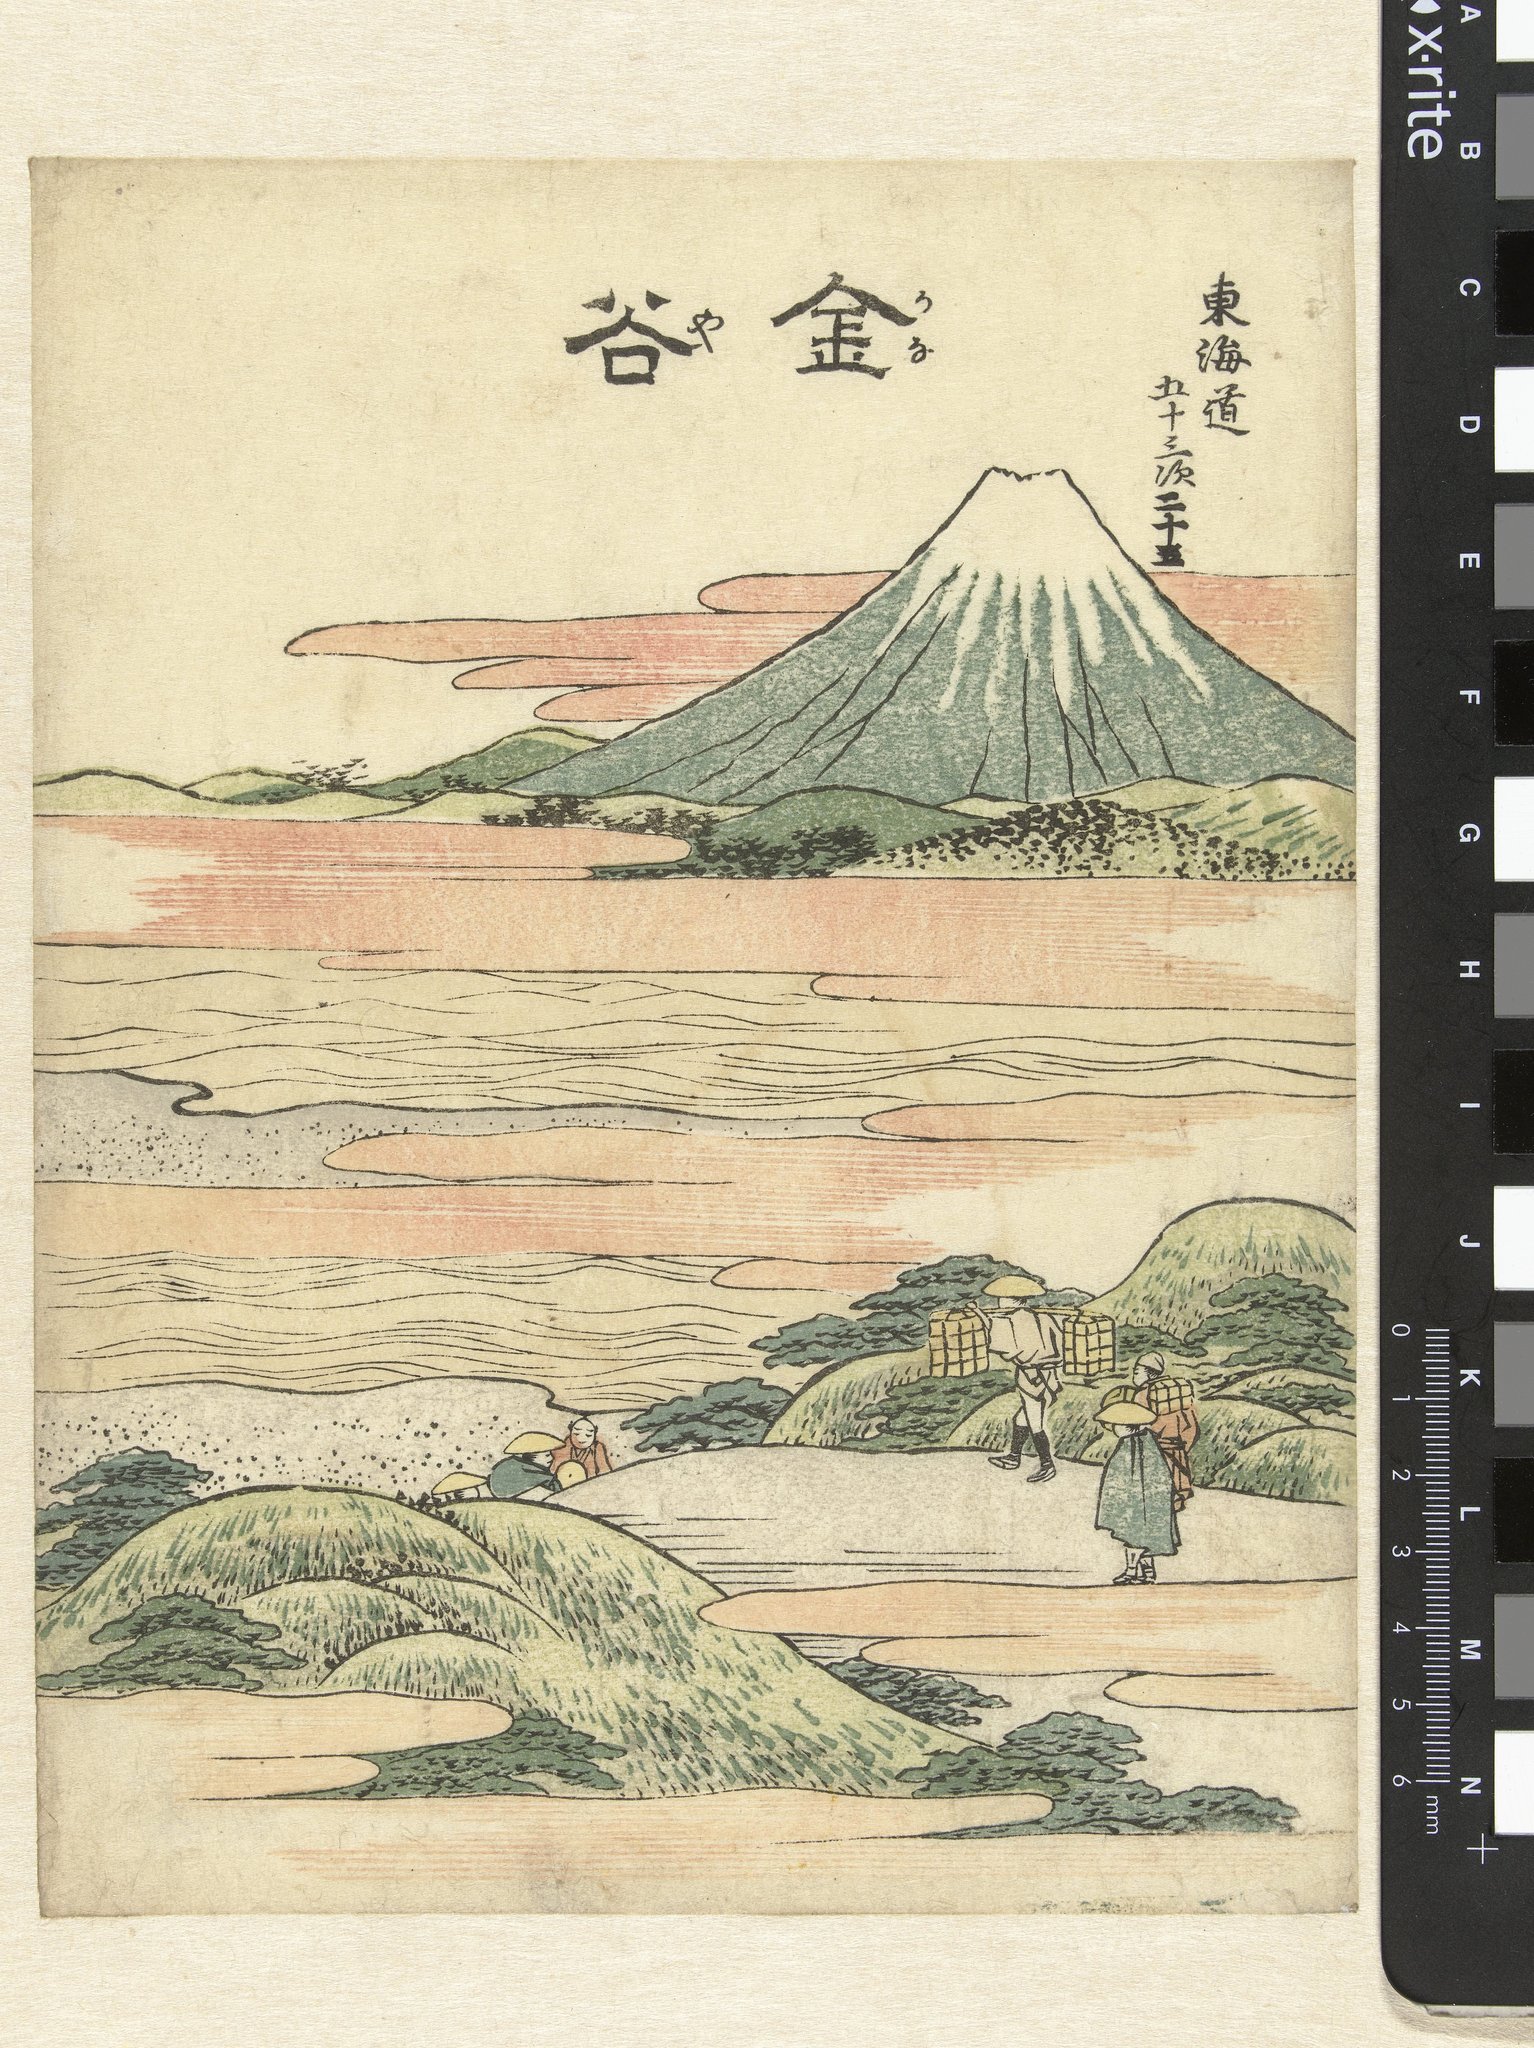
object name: print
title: Kanaya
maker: katsushika hokusai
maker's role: draughtsman, print maker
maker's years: 1760-1849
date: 1825-1830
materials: paper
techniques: woodcut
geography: japan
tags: mountains (+ landscape with figures, staffage), mist, fog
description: Landschap gehuld in mistbanken met de berg Fuji op de achtergrond; op de voorgrond reizigers op de Tokaido, de weg tussen Tokyo en Kyoto.